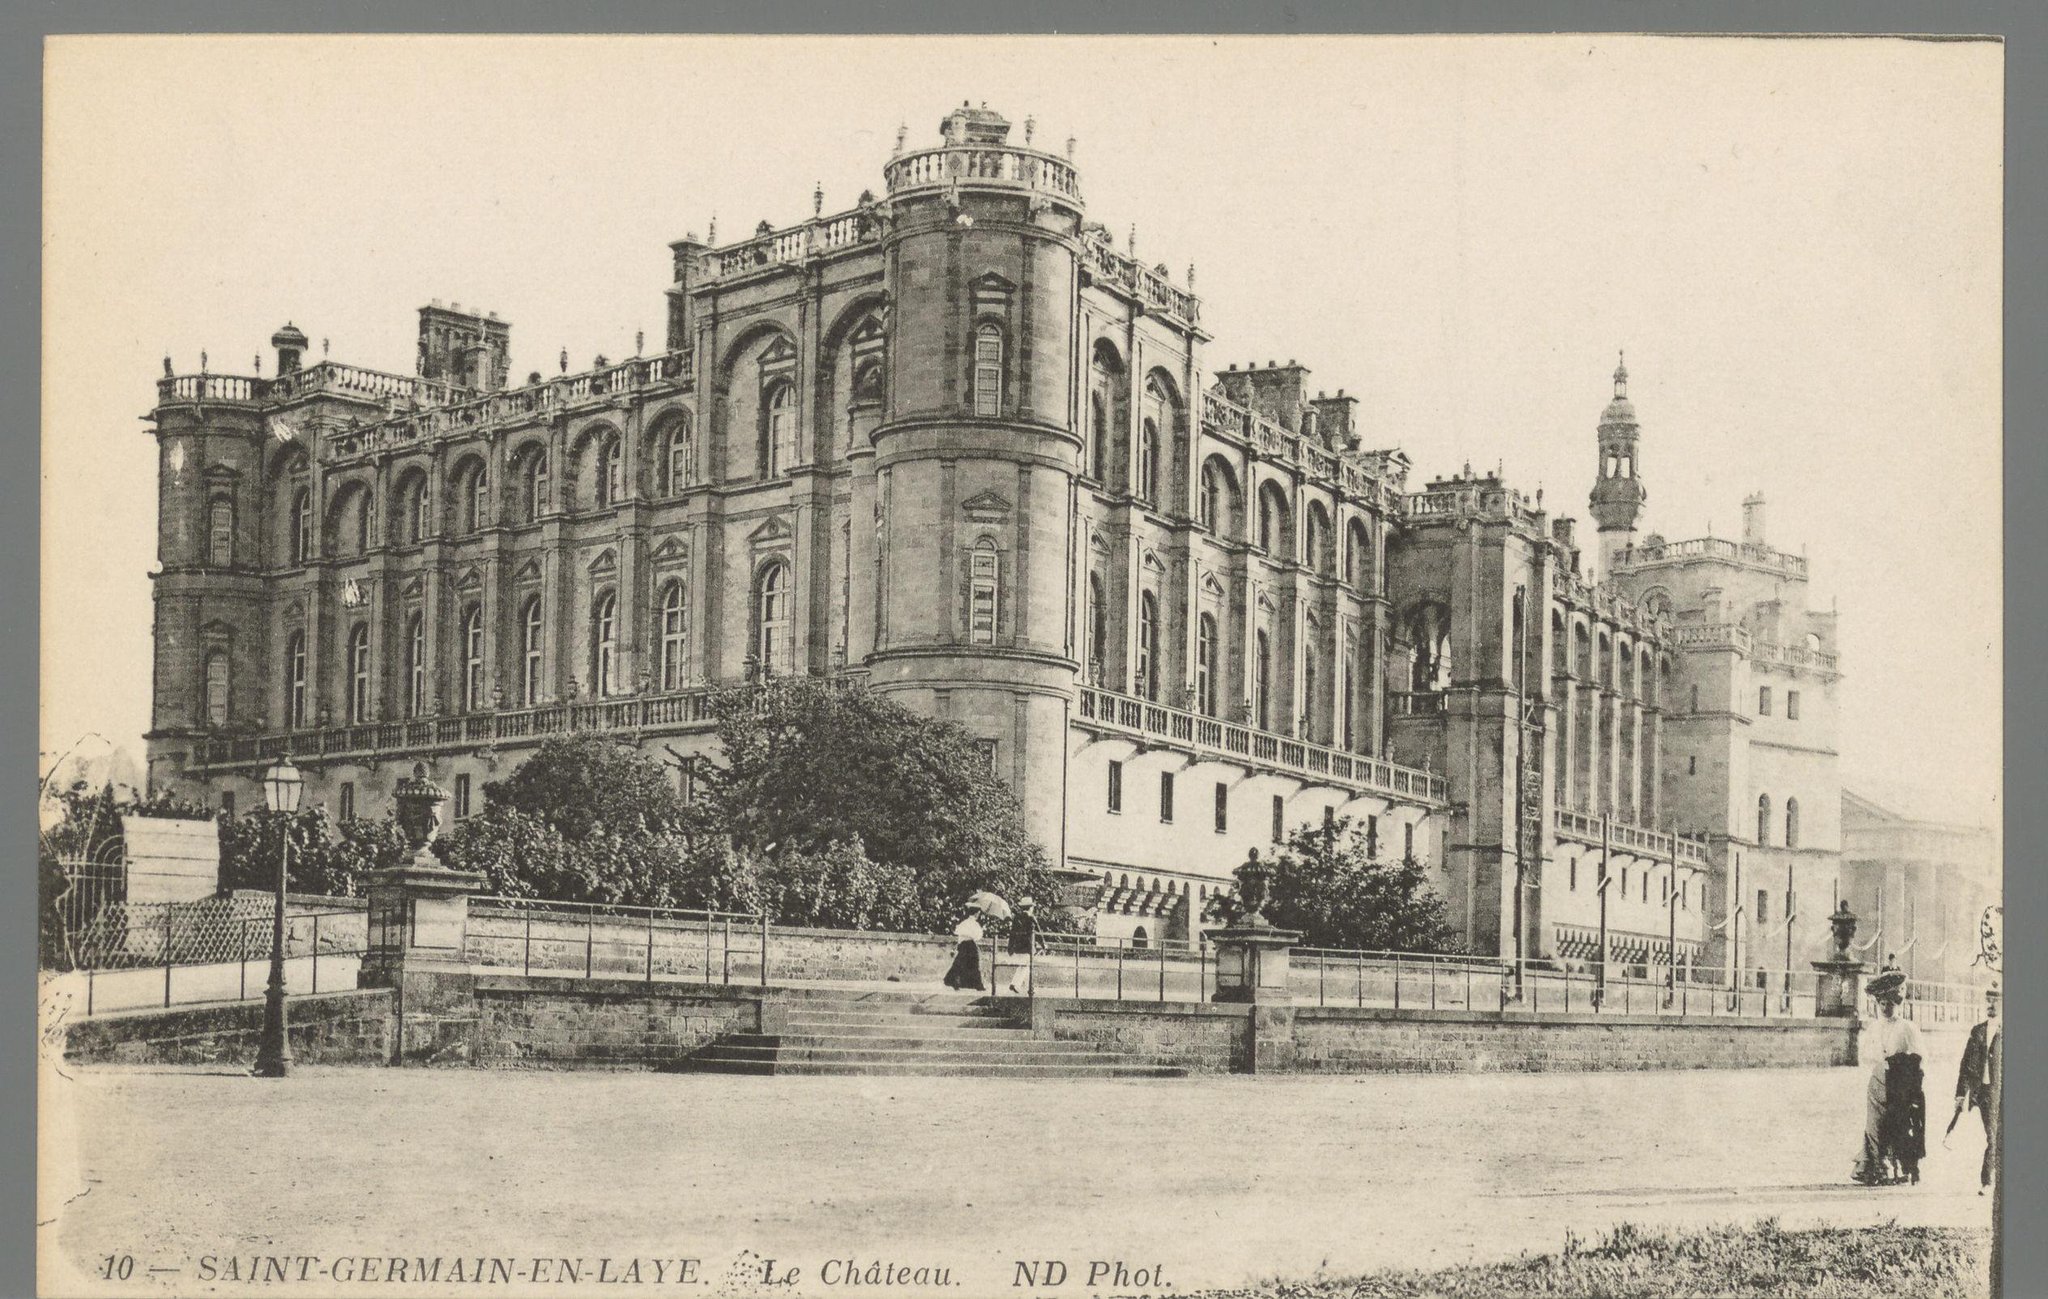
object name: photomechanical print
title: Saint-Germain-en-Laye. Le Château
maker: Anonymous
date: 1903-1918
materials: cardboard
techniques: photograph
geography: paris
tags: public gardens, park (+ city(-scape) with figures, staffage), castle